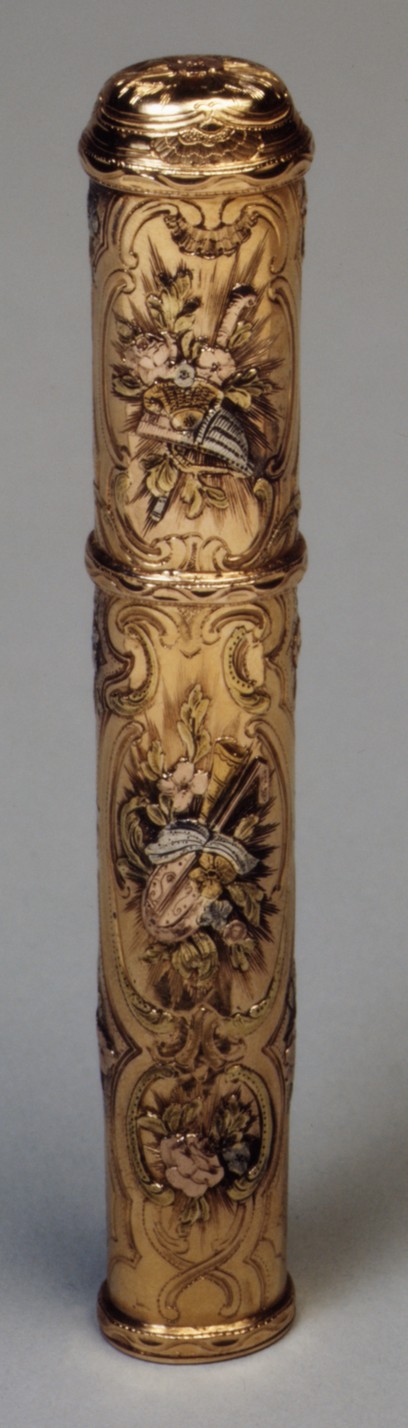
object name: étui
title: Sealing wax case (étui)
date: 1762-1763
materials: gold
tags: coat of arms